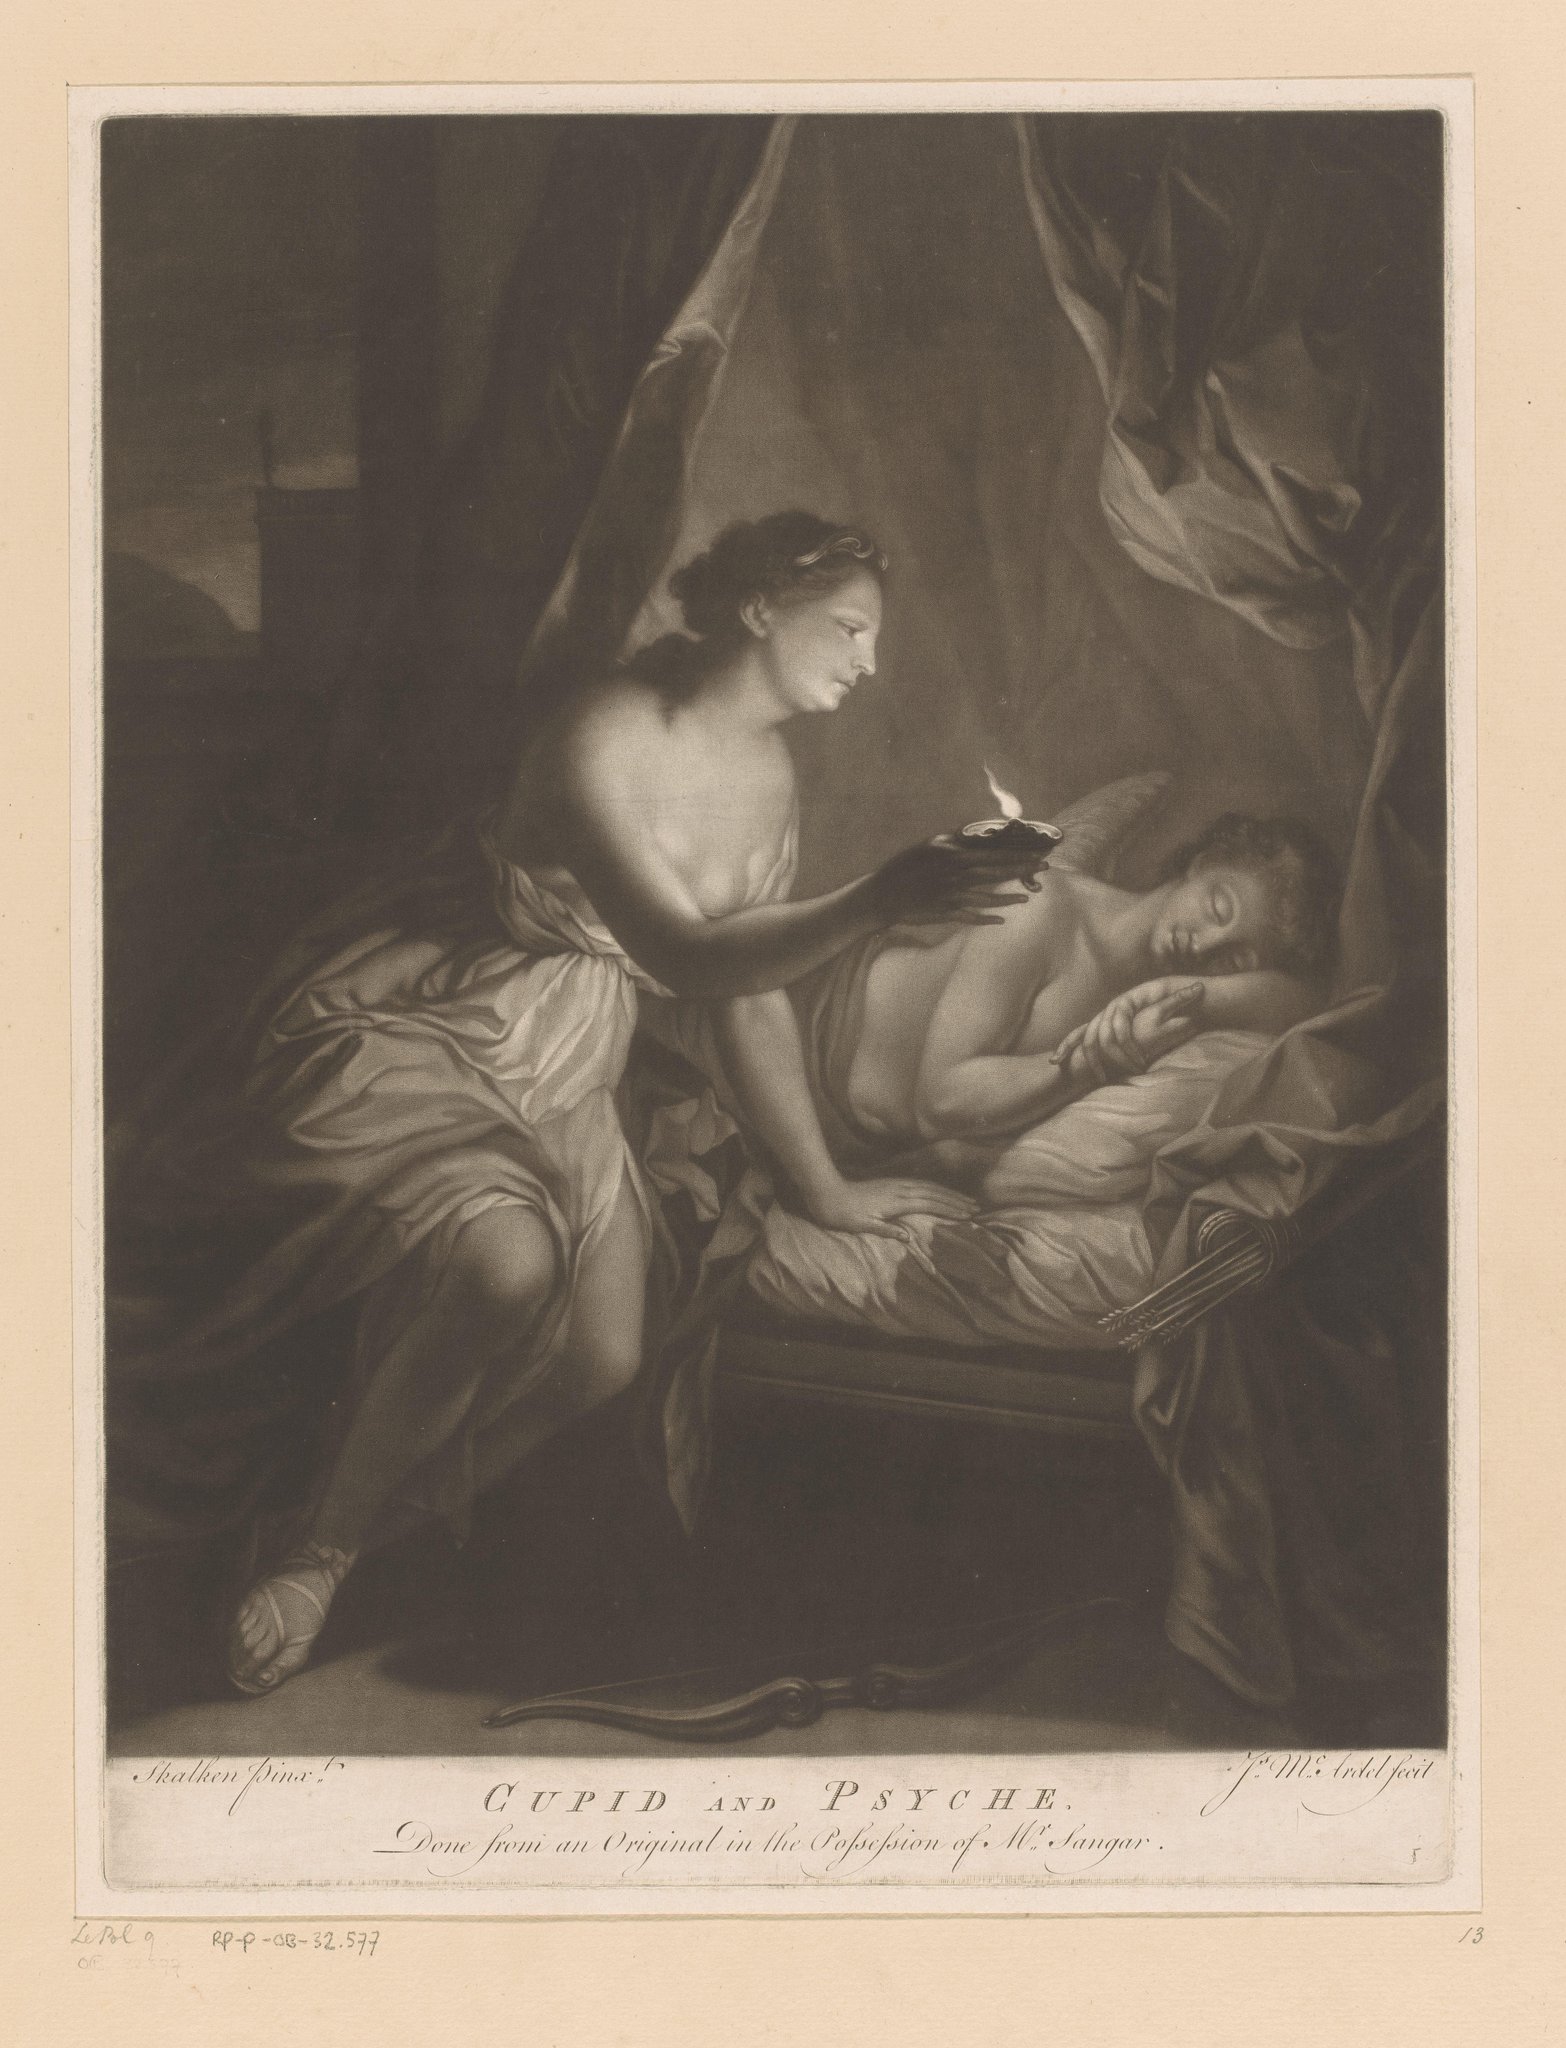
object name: print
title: Cupid and Psyche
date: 1745-1765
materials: paper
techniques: mezzotint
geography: london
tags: psyche, holding a lamp, gazes at the sleeping cupid, who awakens when a drop of hot oil falls on him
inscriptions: collector's mark: Lugt 240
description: Christopher Lennox-Boyd (zie British Museum) noemt drie staten: een staat zonder onderschrift, een staat met de namen van de kunstenaars en een staat met opnieuw gegraveerd onderschrift. RP-P-OB-32.578, waarin de marge nog sporen van het wiegijzer laat zien, zit hier vermoedelijk niet tussen, wat het totaal op vier staten brengt. De volgorde is onduidelijk, maar de staat zonder onderschrift in het British Museum is vermoedelijk de staat tussen deze prent (RP-P-OB-32.577) en de derde staat van Lennox-Boyd (met het opnieuw gegraveerde onderschrift). RP-P-OB-32.578 is waarschijnlijk de eerste staat omdat hier nog sporen van het wiegijzer in de marge te zien zijn.